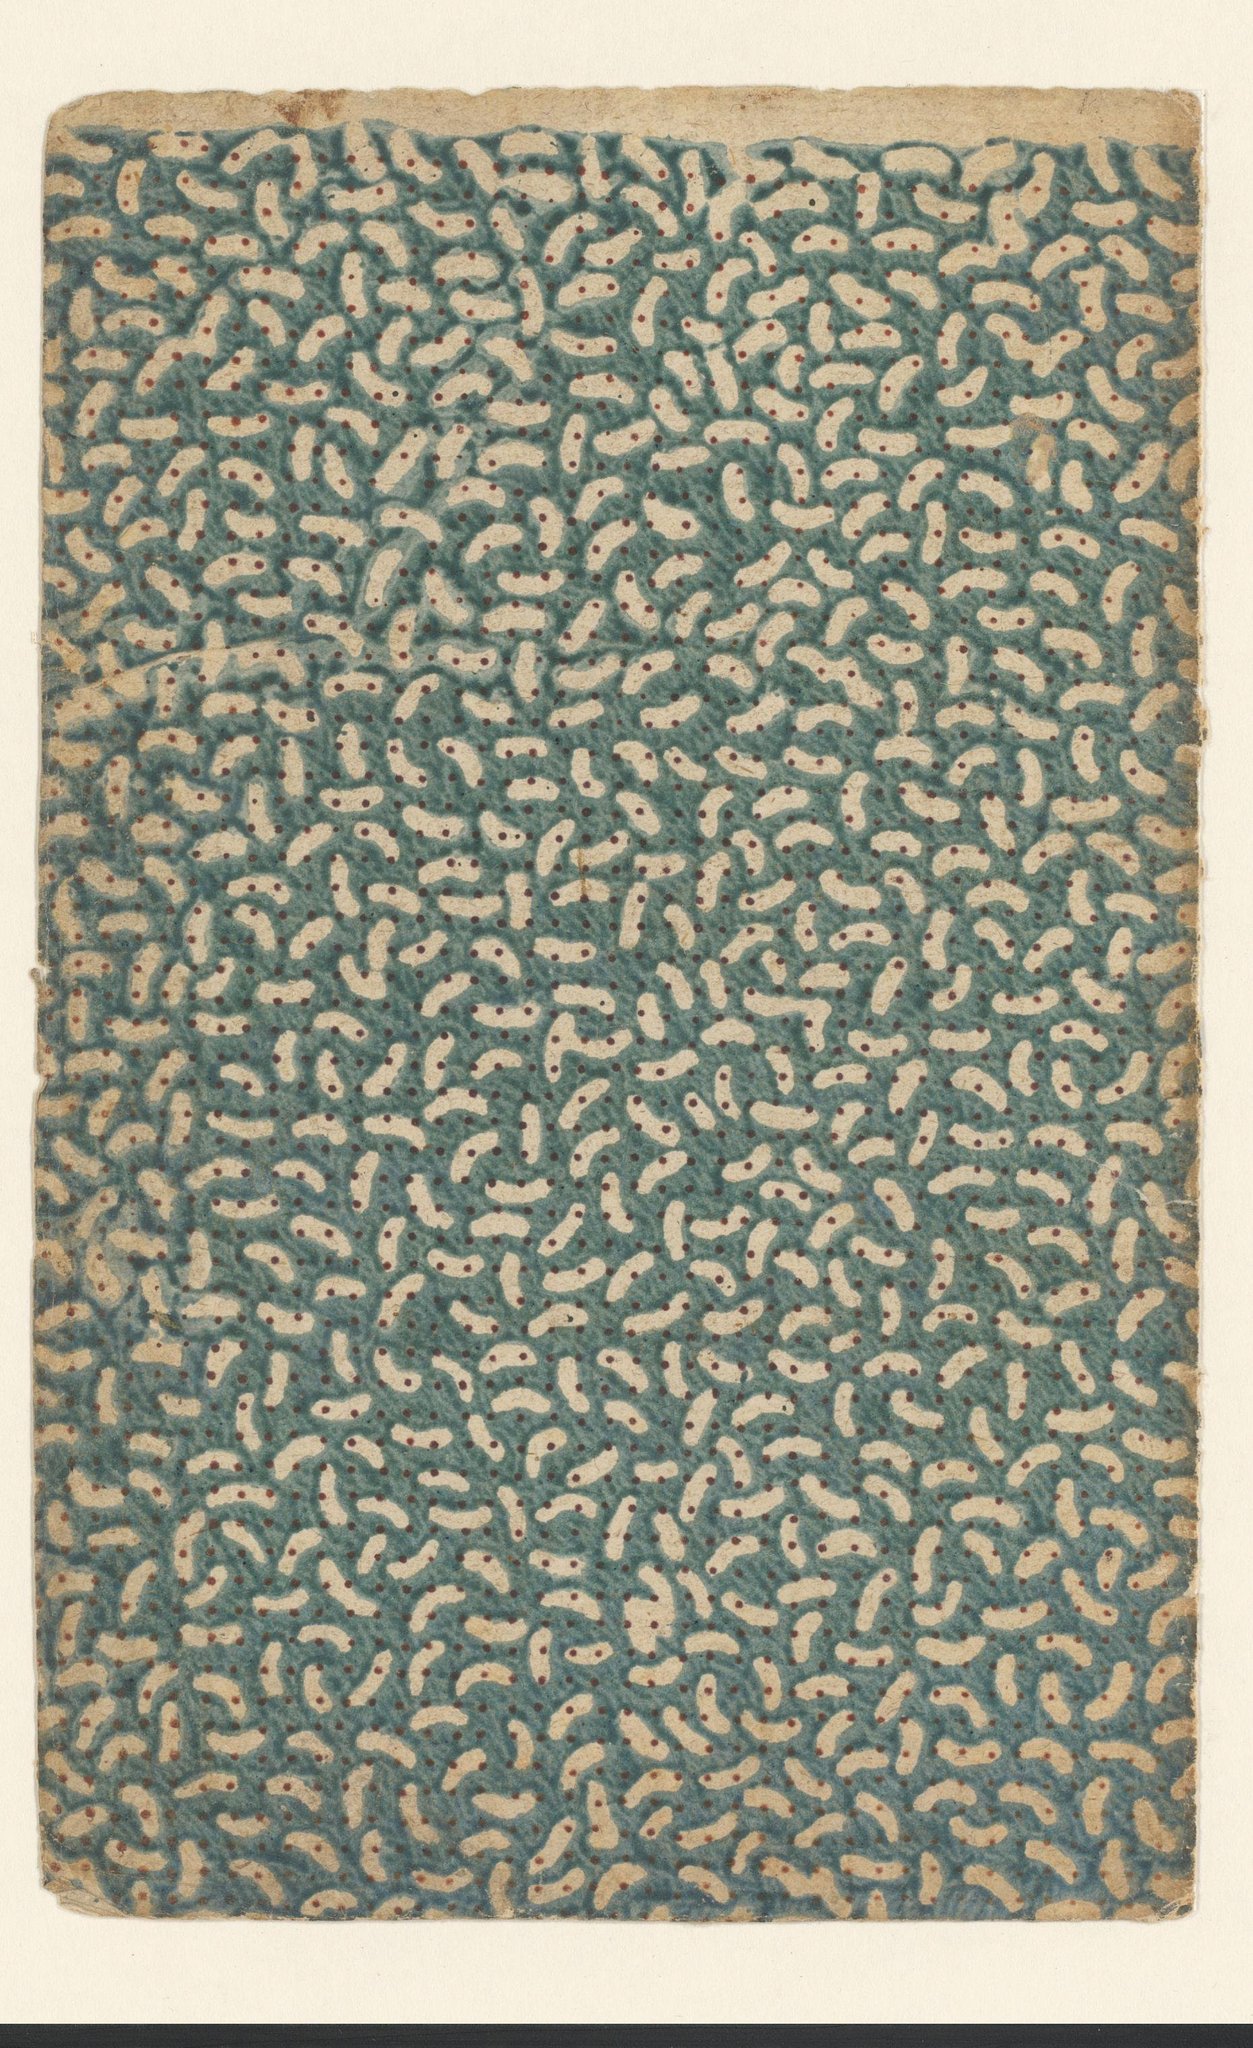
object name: printed paper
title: Blad met stippenpatroon over wormachtig motief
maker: Anonymous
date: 1700-1850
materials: paper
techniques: printing block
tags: fantasy ornament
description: Blad met stippenpatroon over uitgespaarde wormachtig motief. Helft van een omslag.